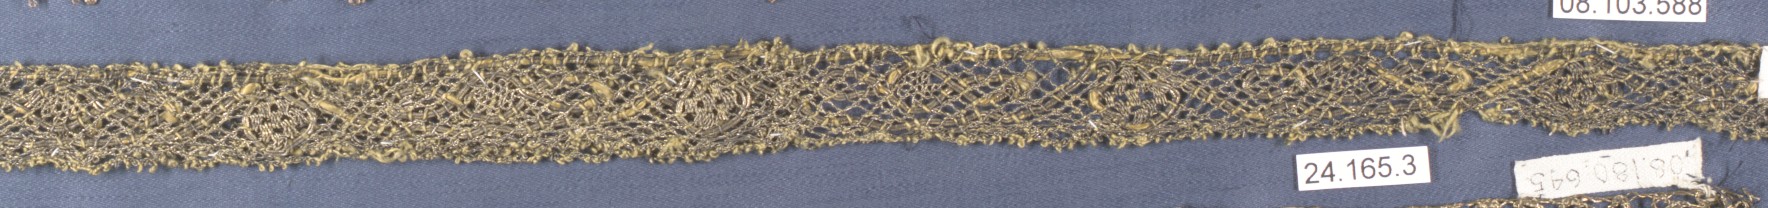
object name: passementerie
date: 1601-1700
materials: metal thread, silk